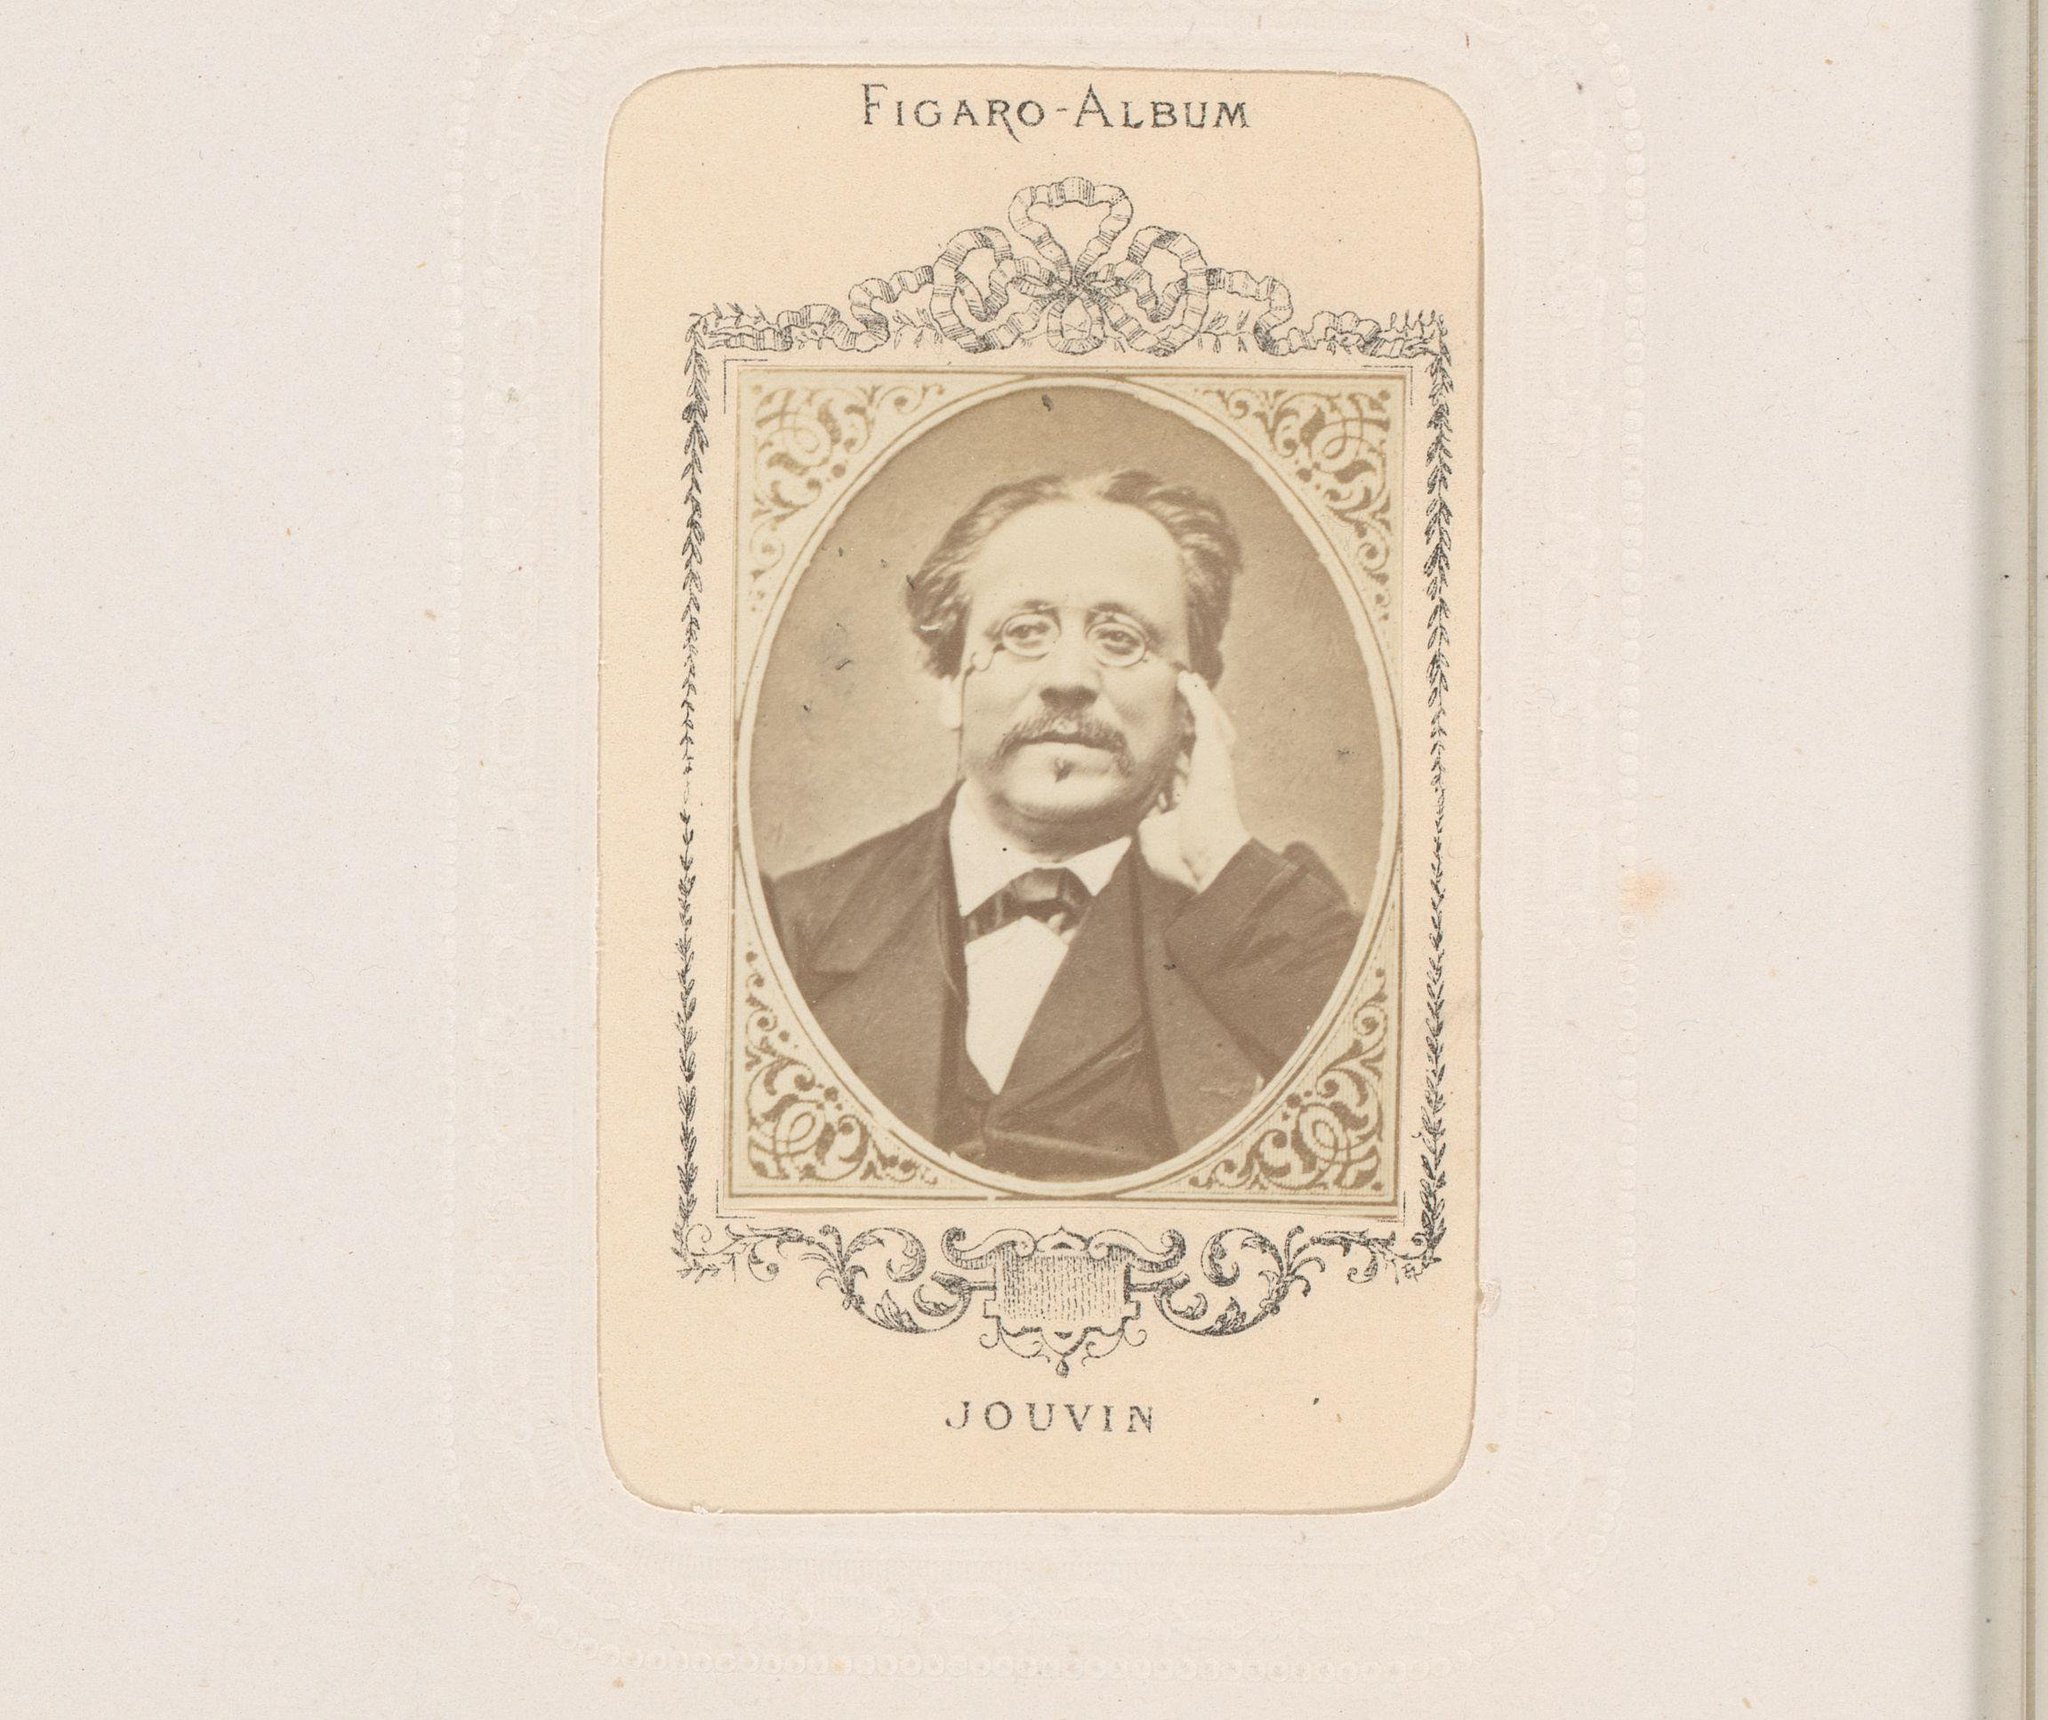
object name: album leaf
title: Fotoreproductie van een portret van Benoît Jouvin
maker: Anonymous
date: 1860-1900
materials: cardboard, photographic support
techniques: albumen print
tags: journalist, reporter, historical persons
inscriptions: inscription: ‘Figaro-Album/ Jouvin/ d'après Legé et Bergeron Phot.’